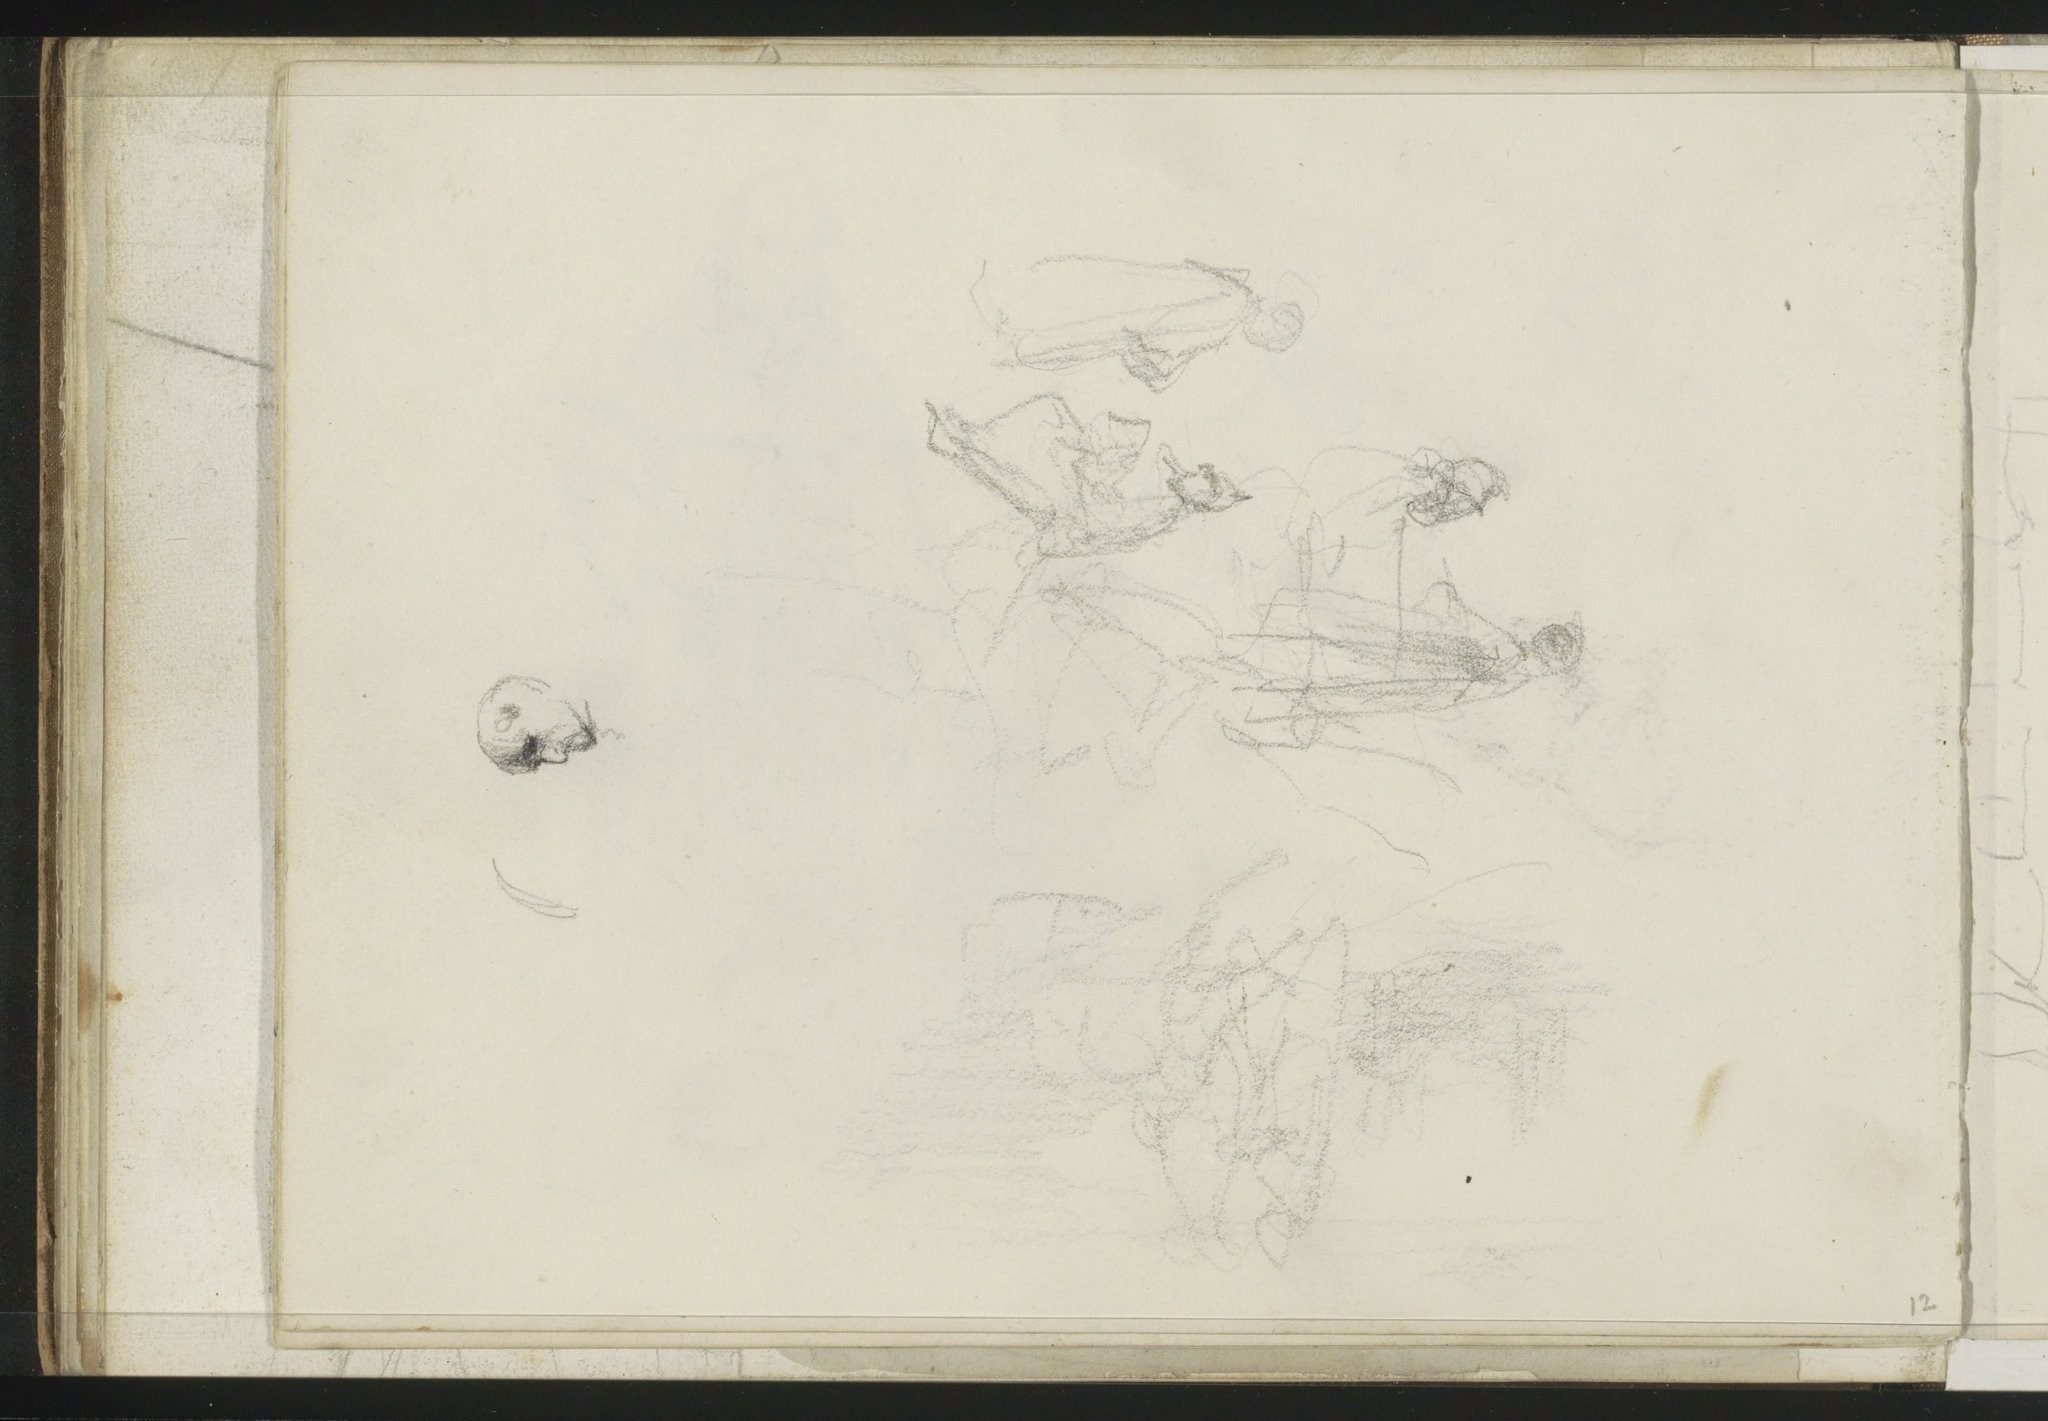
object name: sketchbook leaf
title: Figuurstudies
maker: johannes bosboom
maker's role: draughtsman, painter, print maker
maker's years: 1817-1891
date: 1827-1891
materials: paper, pencil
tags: head (human), anatomy (non-medical)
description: Blad 40 verso uit een schetsboek met 41 pagina's.